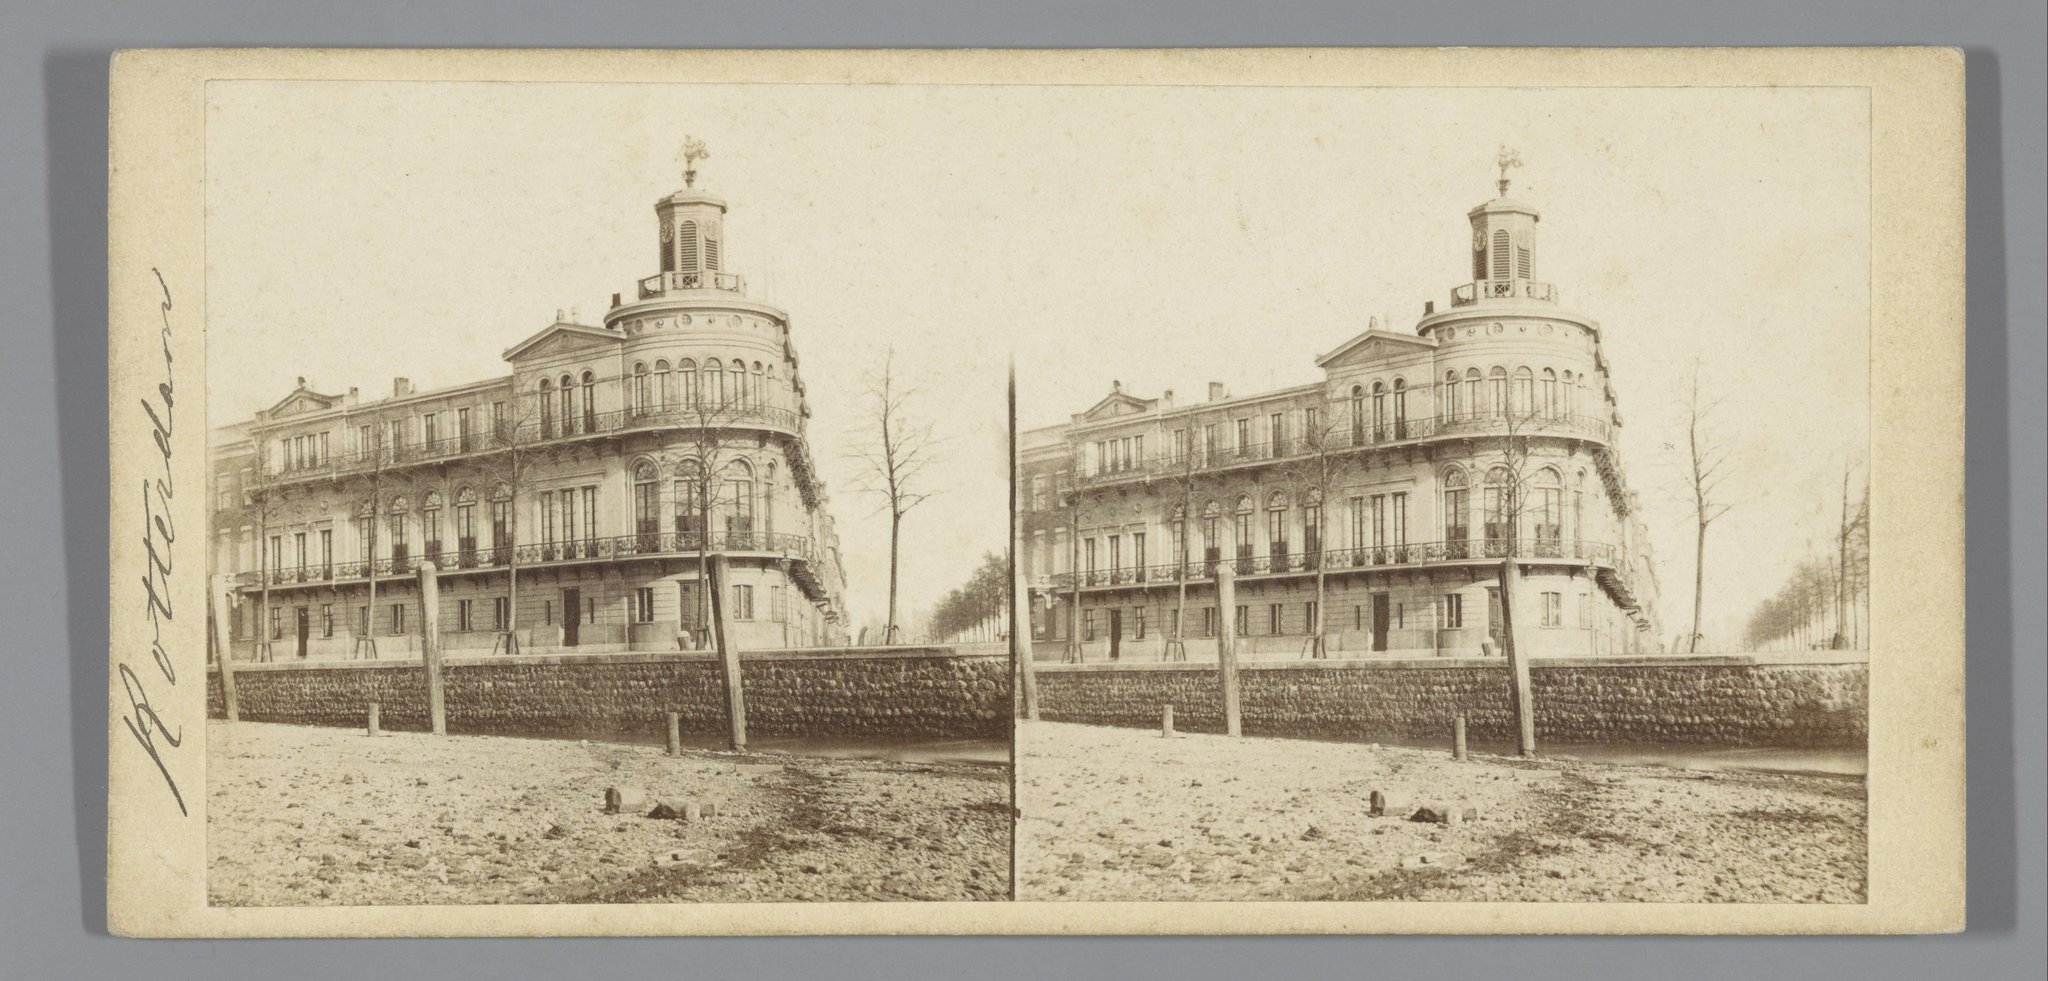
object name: stereograph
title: Gebouw van de Koninklijke Yachtvereniging, Rotterdam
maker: pieter oosterhuis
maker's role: draughtsman, print maker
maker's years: 1816-1885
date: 1859-1865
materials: cardboard, paper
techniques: albumen print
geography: rotterdam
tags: club, meeting place, rotterdam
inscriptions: inscription: ‘P’, inscription: ‘B’, number: ‘No. 104.’, number: ‘No. 2’, inscription: ‘Rotterdam’, number: ‘39’